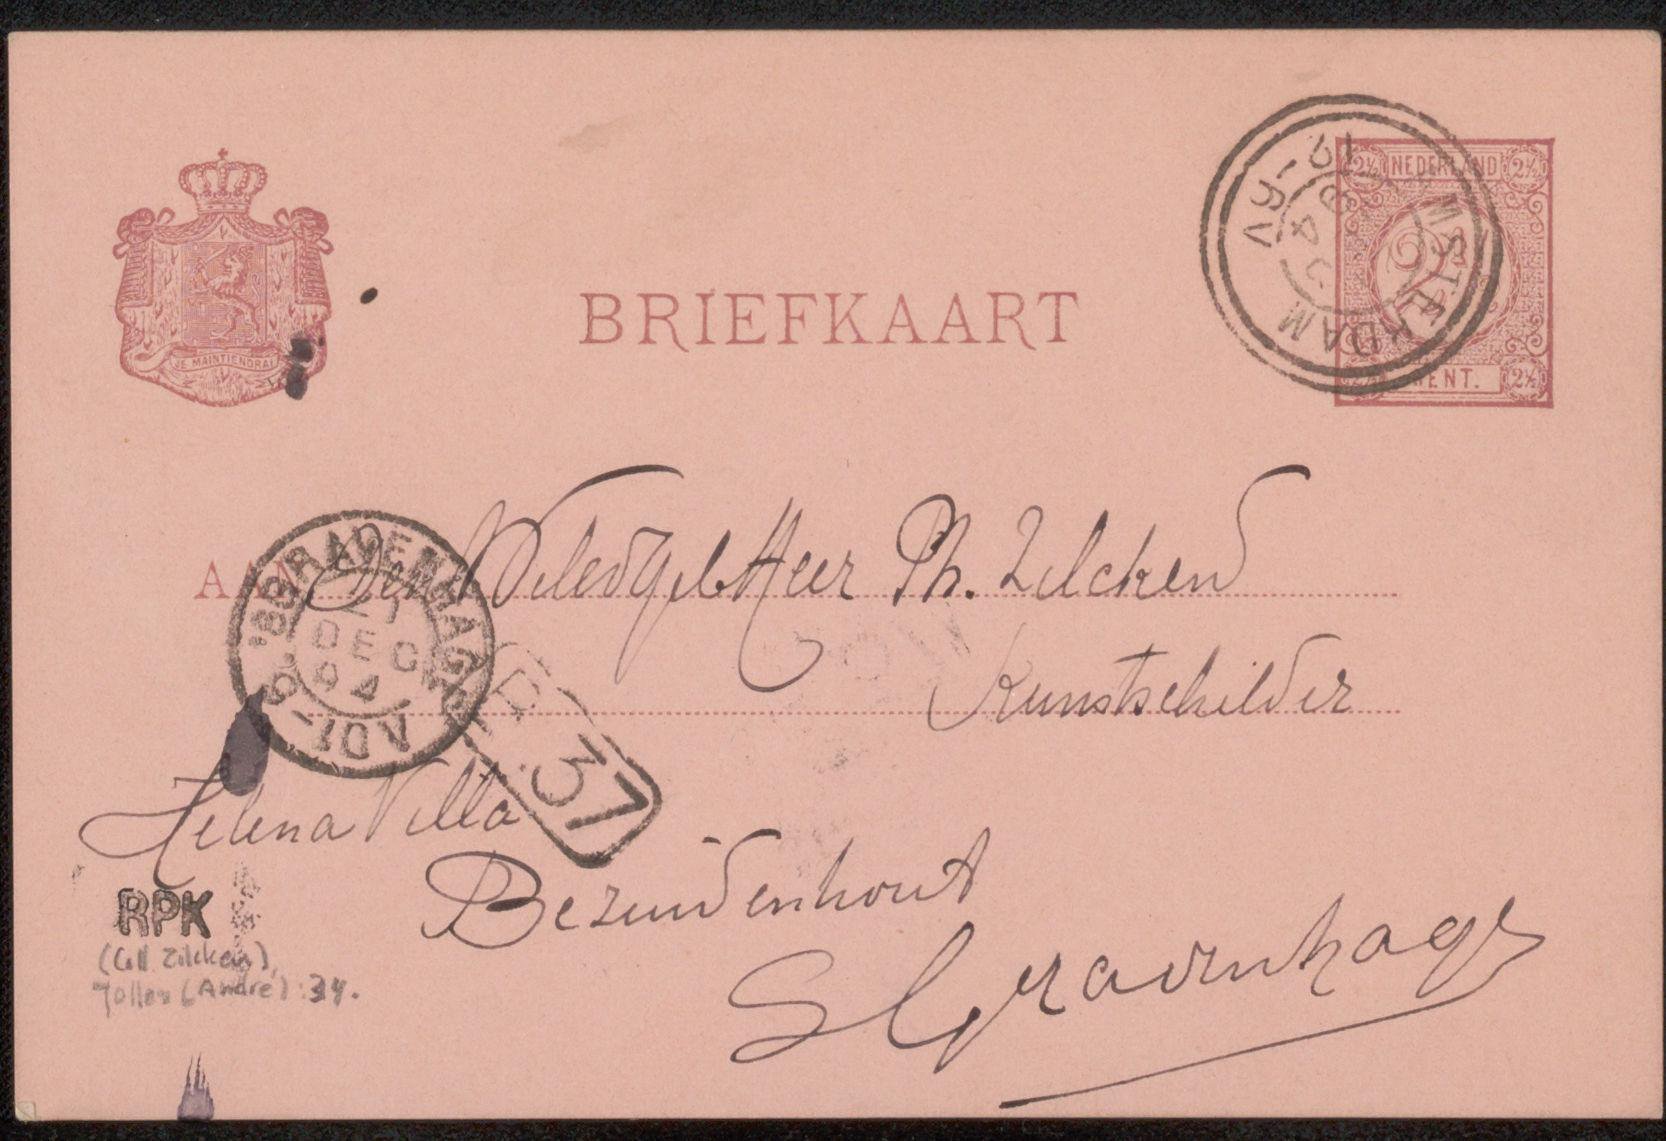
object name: postcard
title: Briefkaart aan Philip Zilcken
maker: andré jolles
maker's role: journalist, kunsthistoricus, letterkundige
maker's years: 1874-1946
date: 1894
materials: cardboard, ink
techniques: pen, writing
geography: amsterdam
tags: politician, jacob nicolaas van hall, the hague, painter, draughtsman, philip zilcken, italy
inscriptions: collector's mark: ‘RPK’